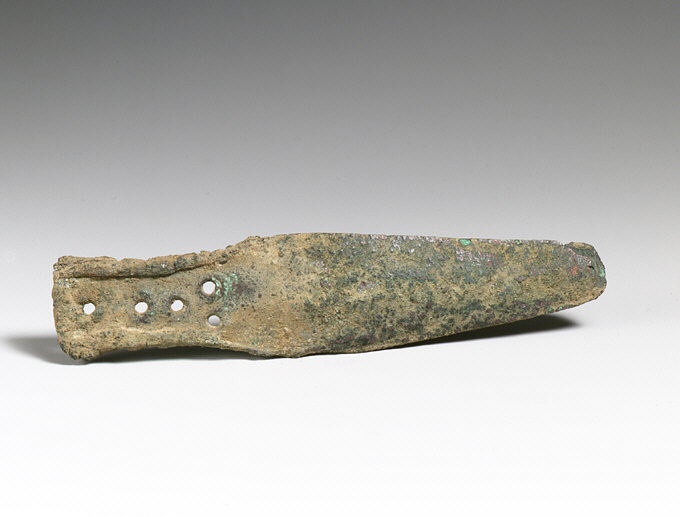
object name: dagger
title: Bronze dagger blade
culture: cypriot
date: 1600-1050 BCE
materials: bronze